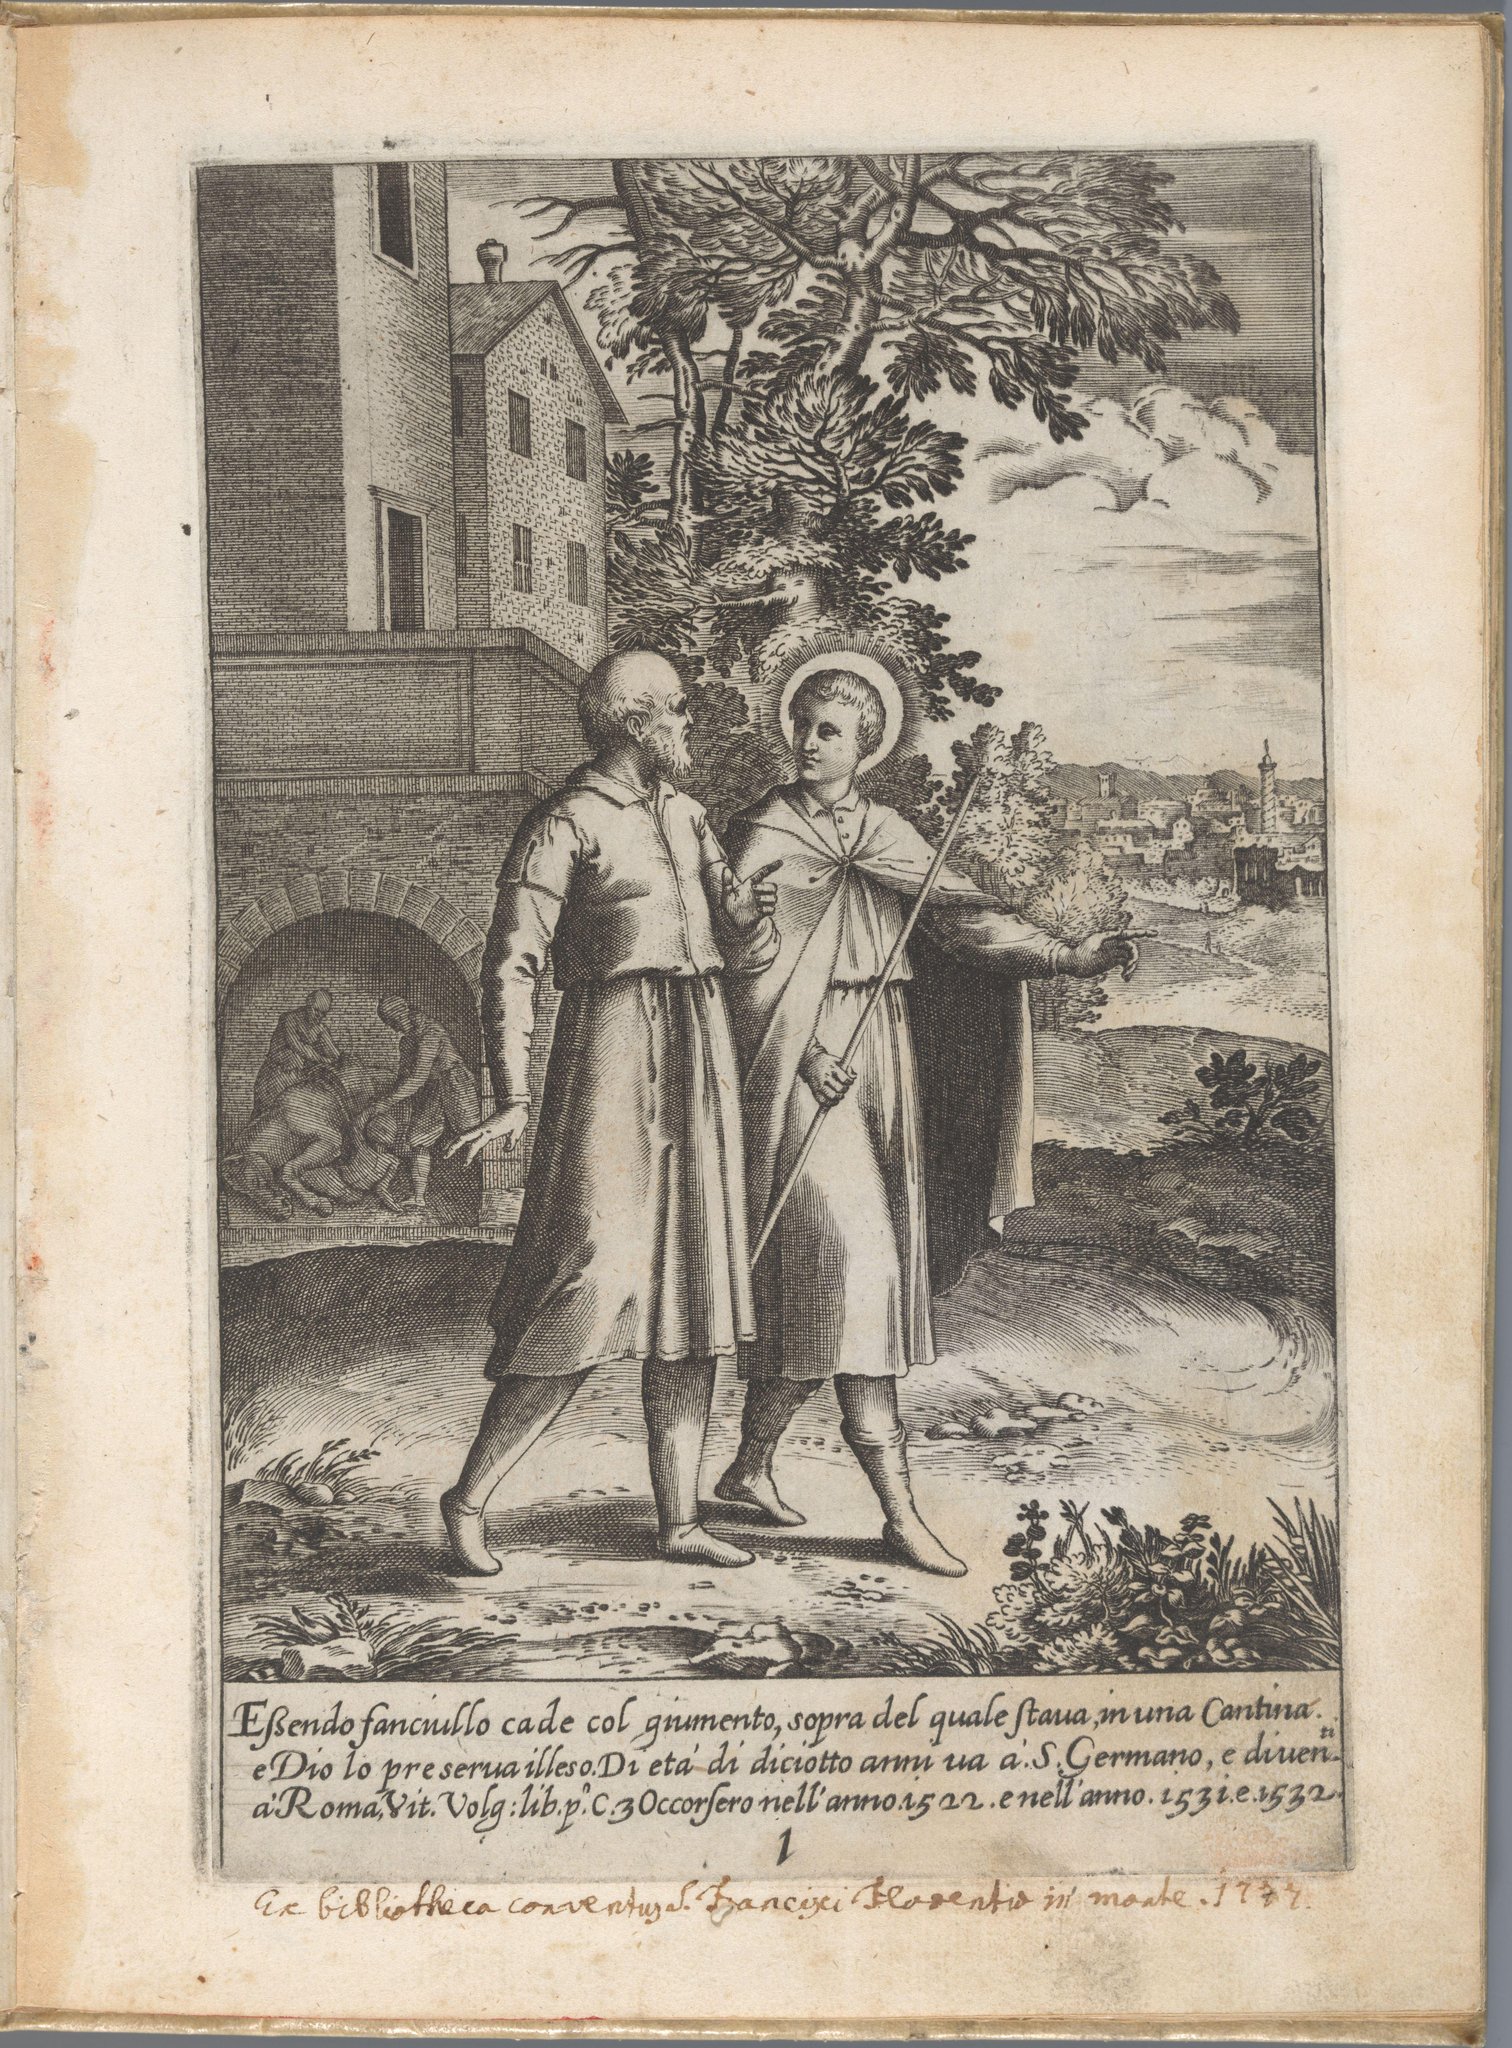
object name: print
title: Leven van de heilige Filippo Neri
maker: luca ciamberlano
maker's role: painter, print maker, publisher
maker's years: 1570-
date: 1630-1641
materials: paper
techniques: engraving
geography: rome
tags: clergyman, the founder of the congregation of the oratory (oratorians) philip neri; possible attributes: lily, rosary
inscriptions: collector's mark: Lugt 2228, collector's mark: Lugt 2760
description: Twee scènes uit de jeugd van Filippo Neri. Als jongen valt hij van een ezel en wordt door God beschermd (1522), als achttienjarige gaat hij met de heilige Germano naar Rome (1531-1532). Prent nr. 1 in een serie van 44 prenten met scènes uit het leven van de heilige Filippo Neri.